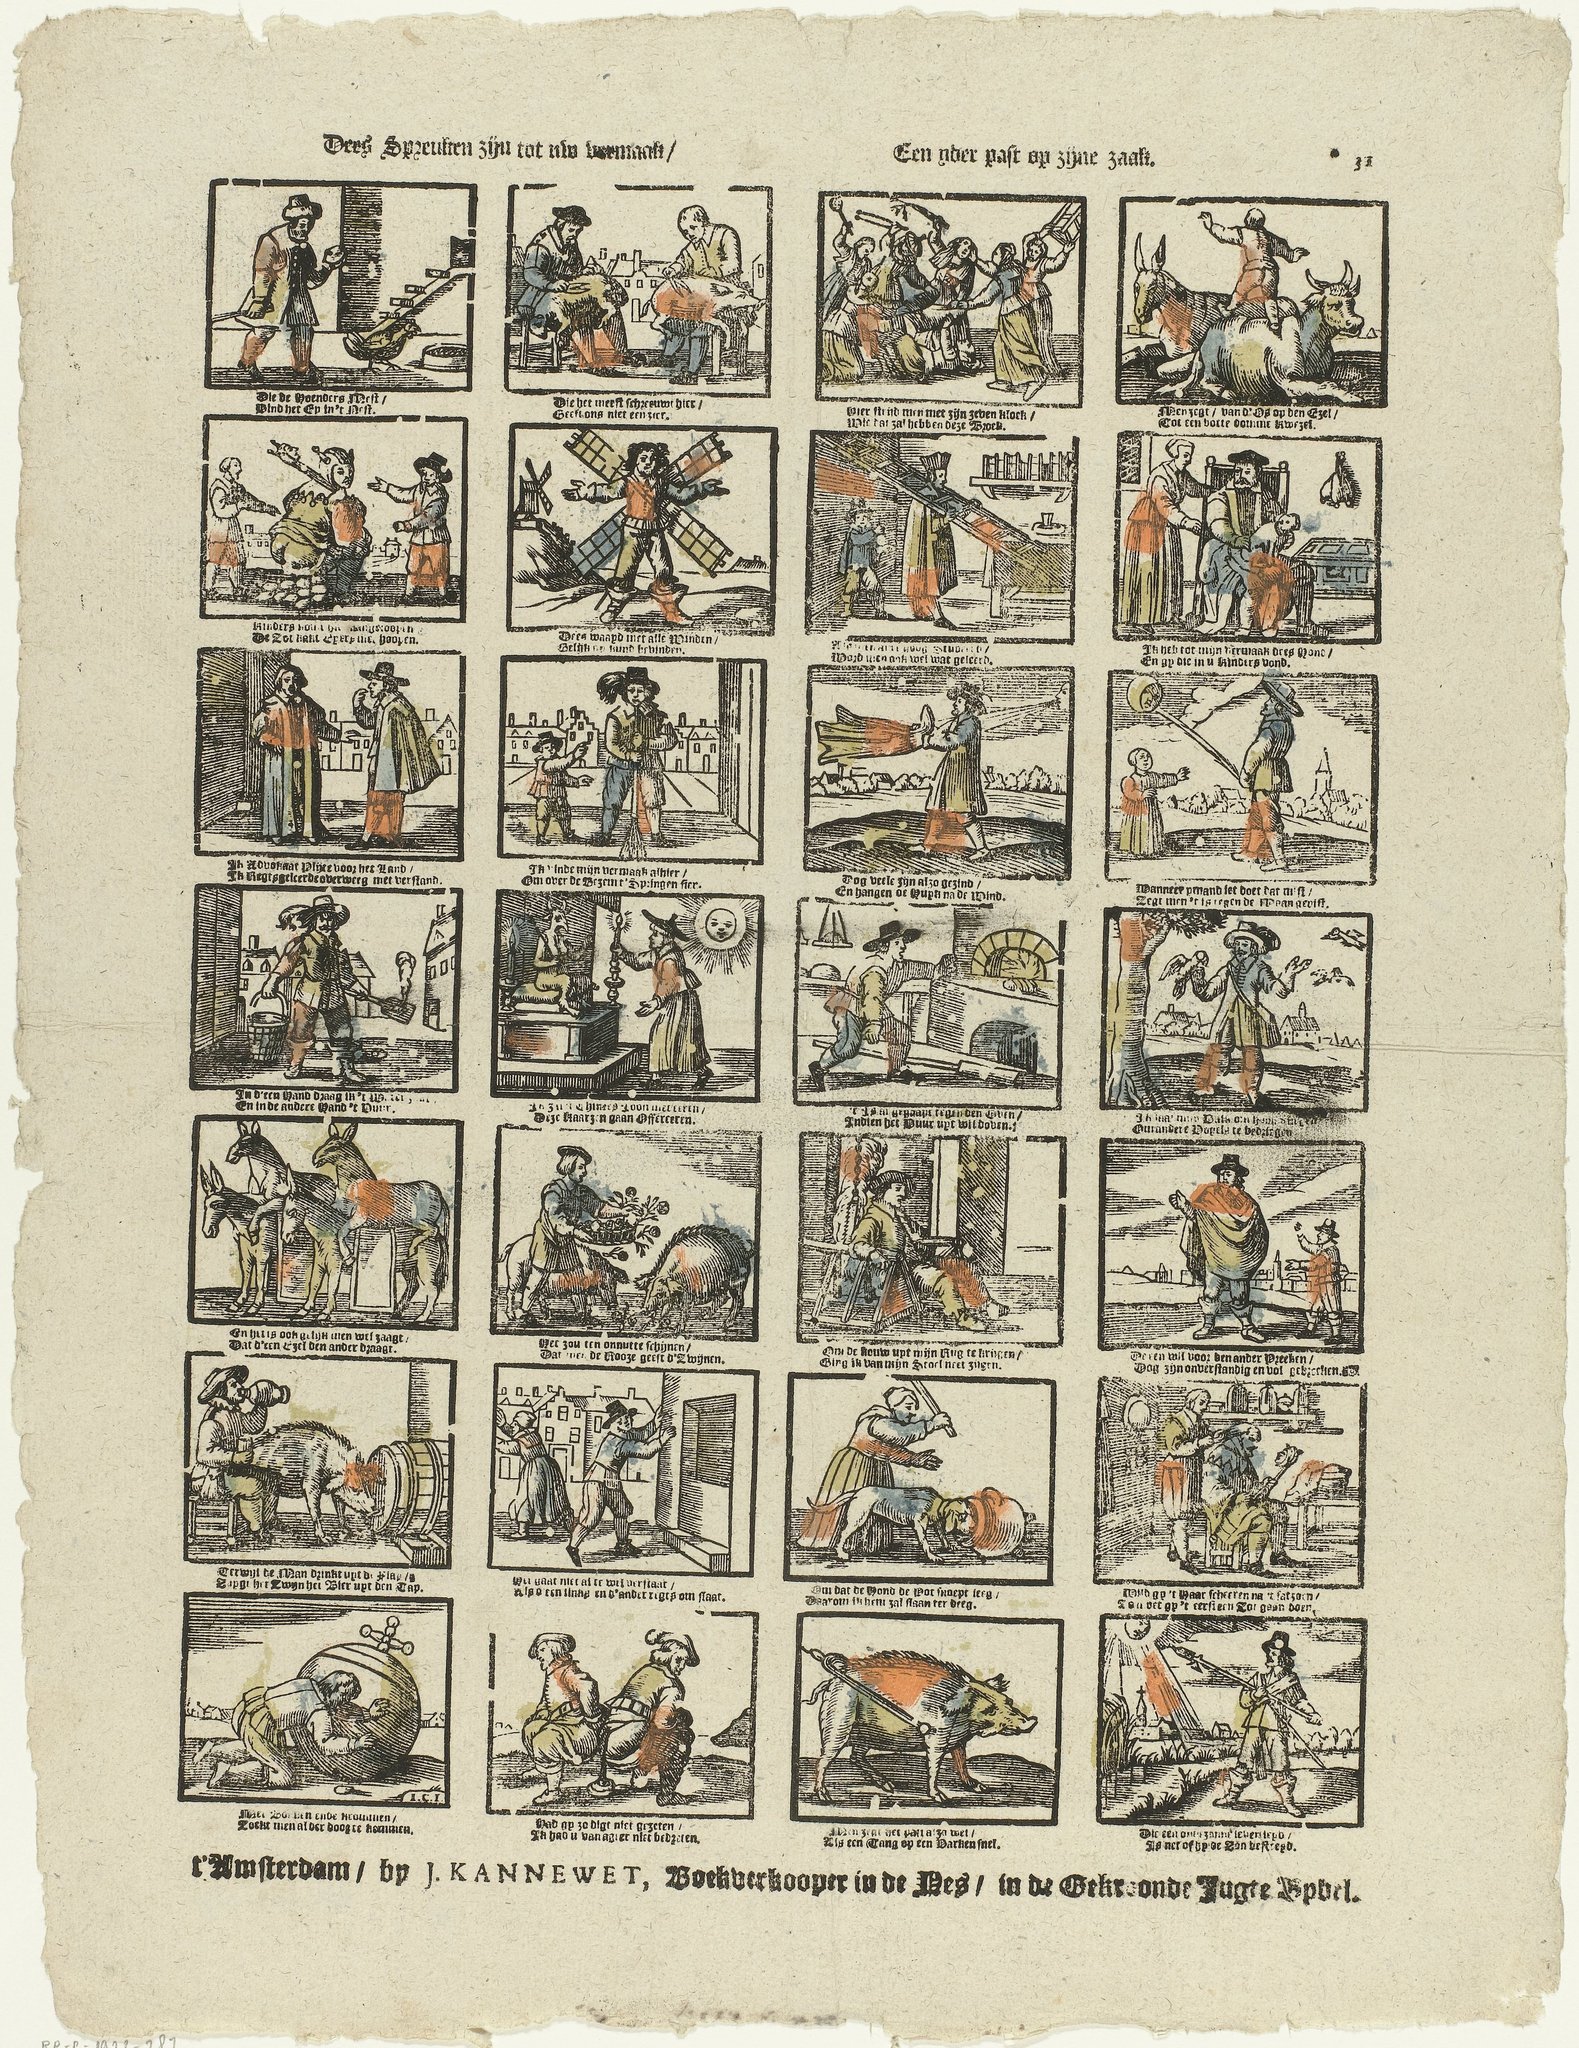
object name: popular print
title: Dees spreuken zijn tot uw vermaak / Een yder past op zijne zaak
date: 1725-1780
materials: paper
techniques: letterpress printing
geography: amsterdam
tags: proverbs, sayings, etc.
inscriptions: collector's mark: Lugt 2760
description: Blad met 28 verbeeldingen van spreekwoorden. Onder elke afbeelding een tweeregelig vers. Genummerd rechtsboven: *31.